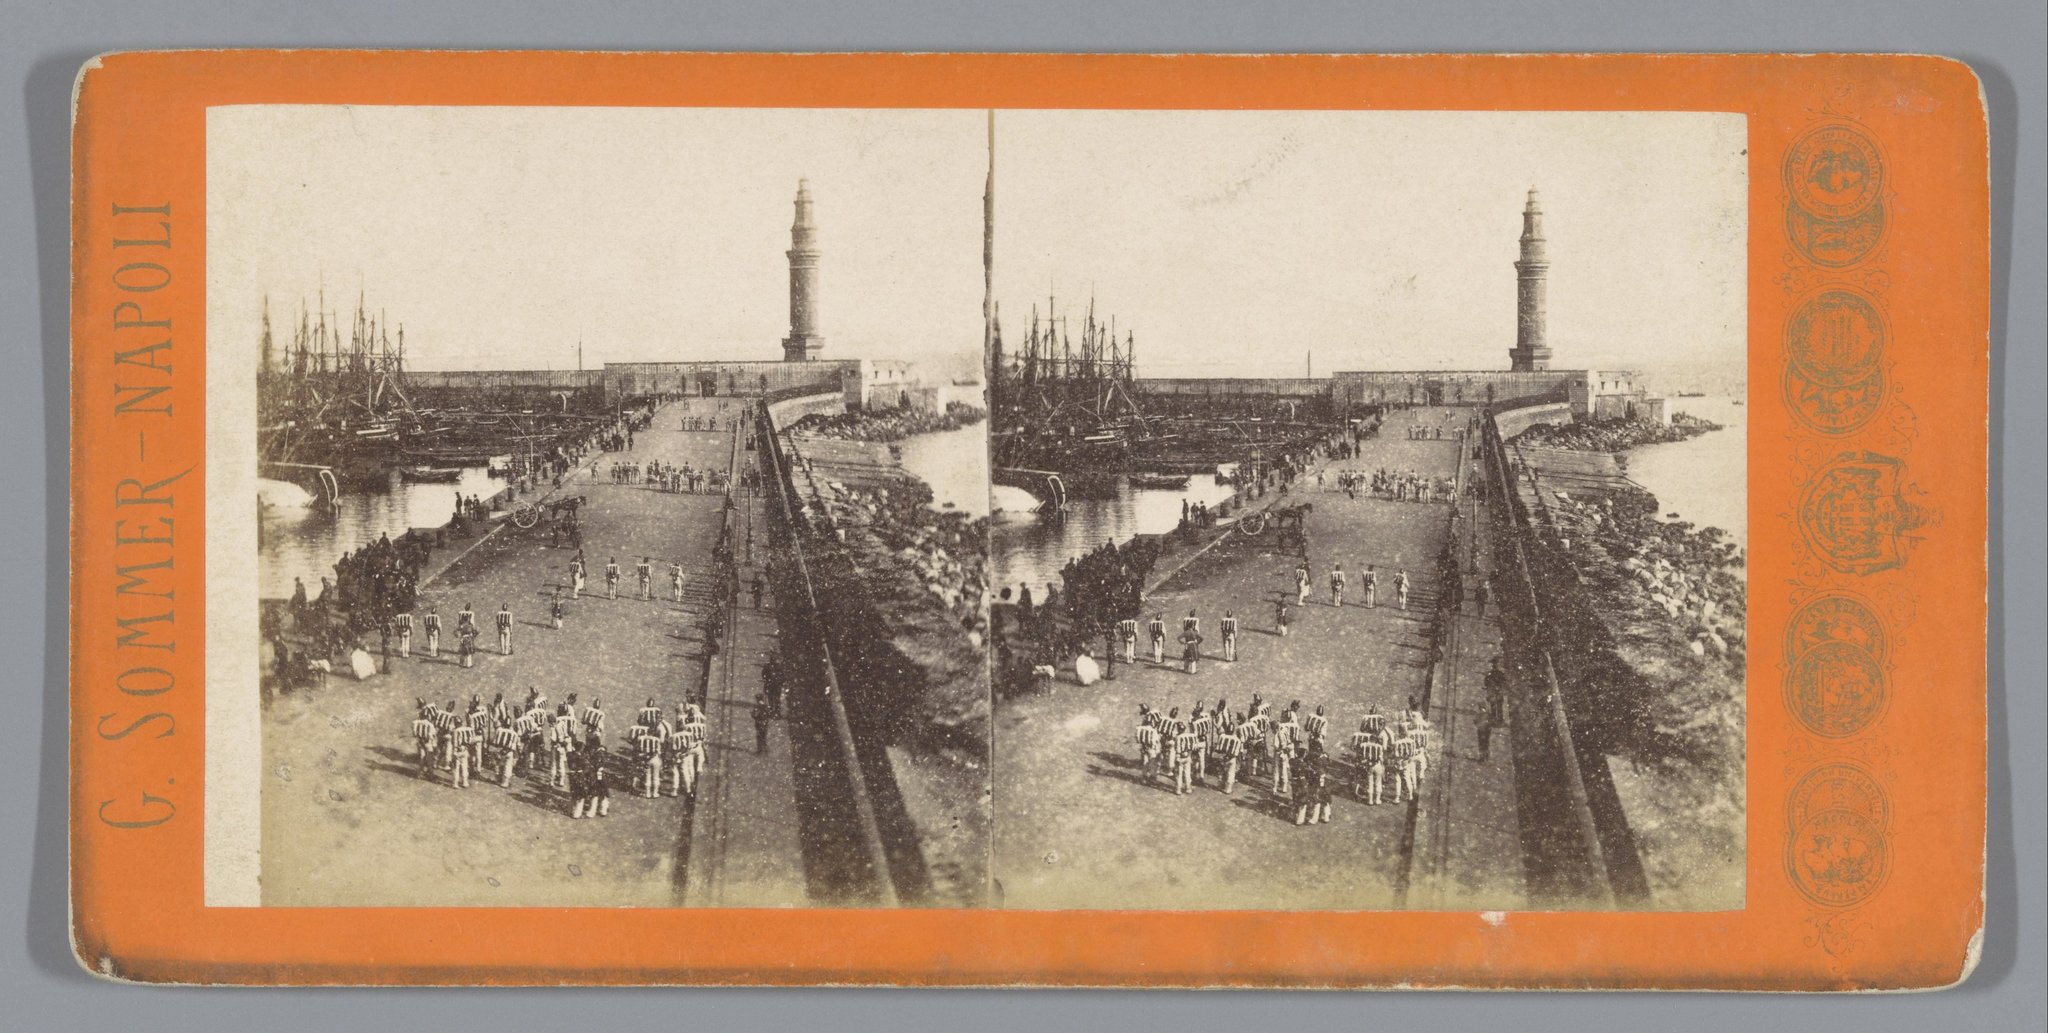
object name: stereograph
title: Gezicht op een kade in Napels met een vuurtoren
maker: giorgio sommer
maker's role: fotograaf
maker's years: 1834-1914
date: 1860-1880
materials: cardboard, photographic support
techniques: albumen print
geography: naples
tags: lighthouse, lightship, quay, naples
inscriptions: inscription: ‘Napels’